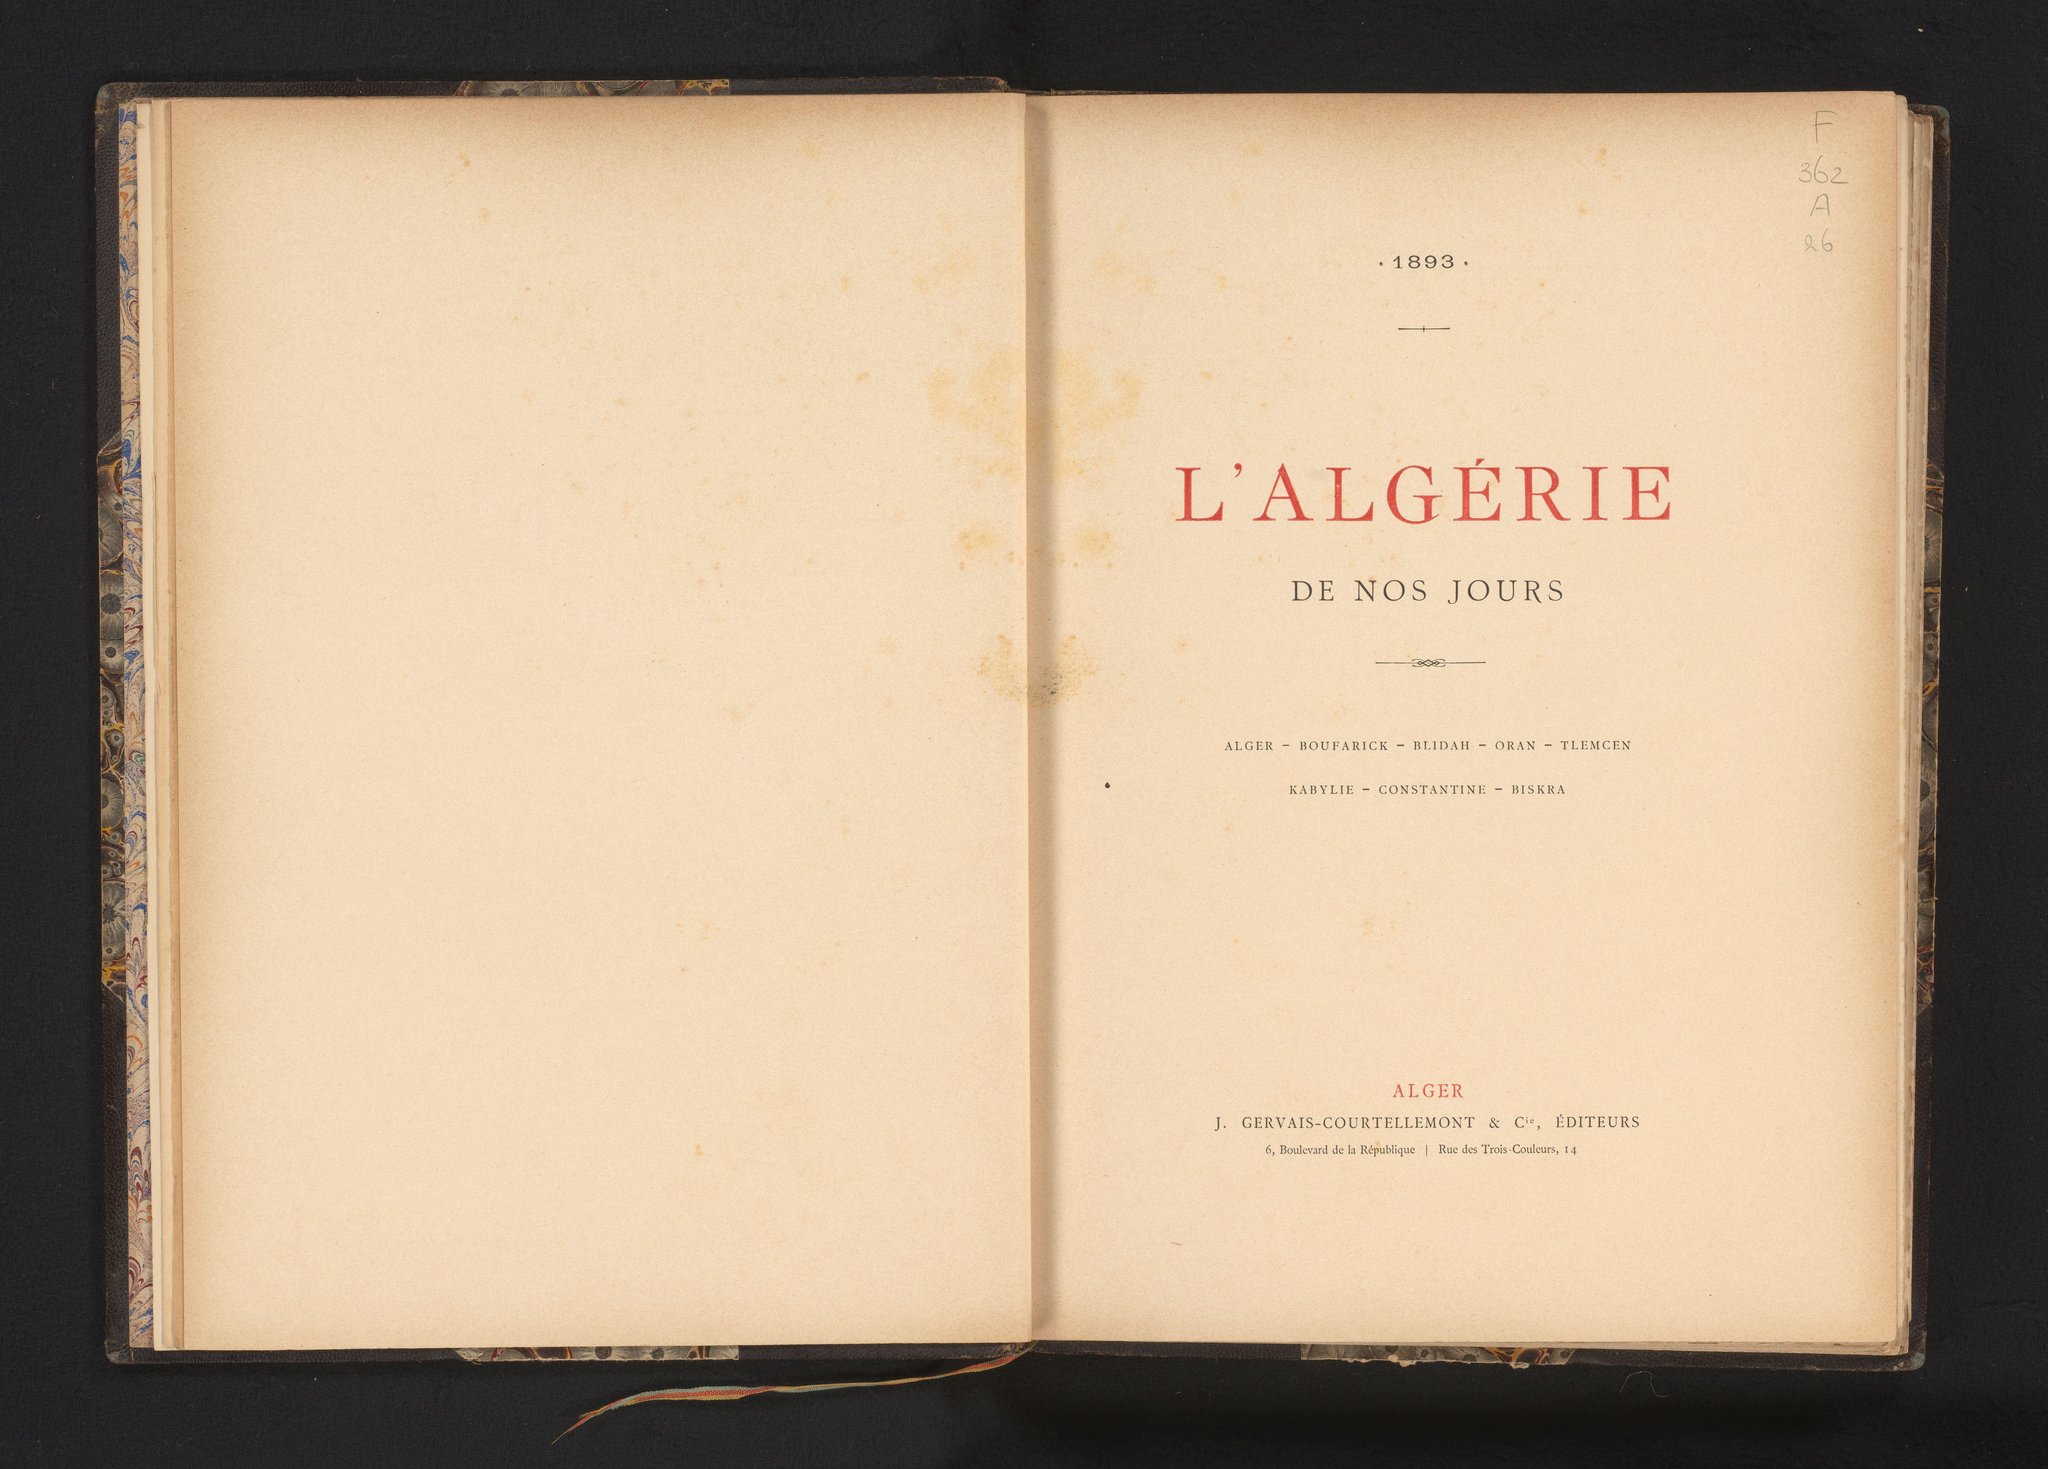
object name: book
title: L'Algérie de nos jours : Alger, Boufarick, Blidah, Oran, Tlemcen, Kabylie, Constantine, Biskra / [Paul Margueritte (...) et al.]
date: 1893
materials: cardboard, leather, linen, paper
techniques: marbled paper, photograph, printing, marbling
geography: algiers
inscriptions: date: ‘OCT/ 2006’, name: ‘roussems.’